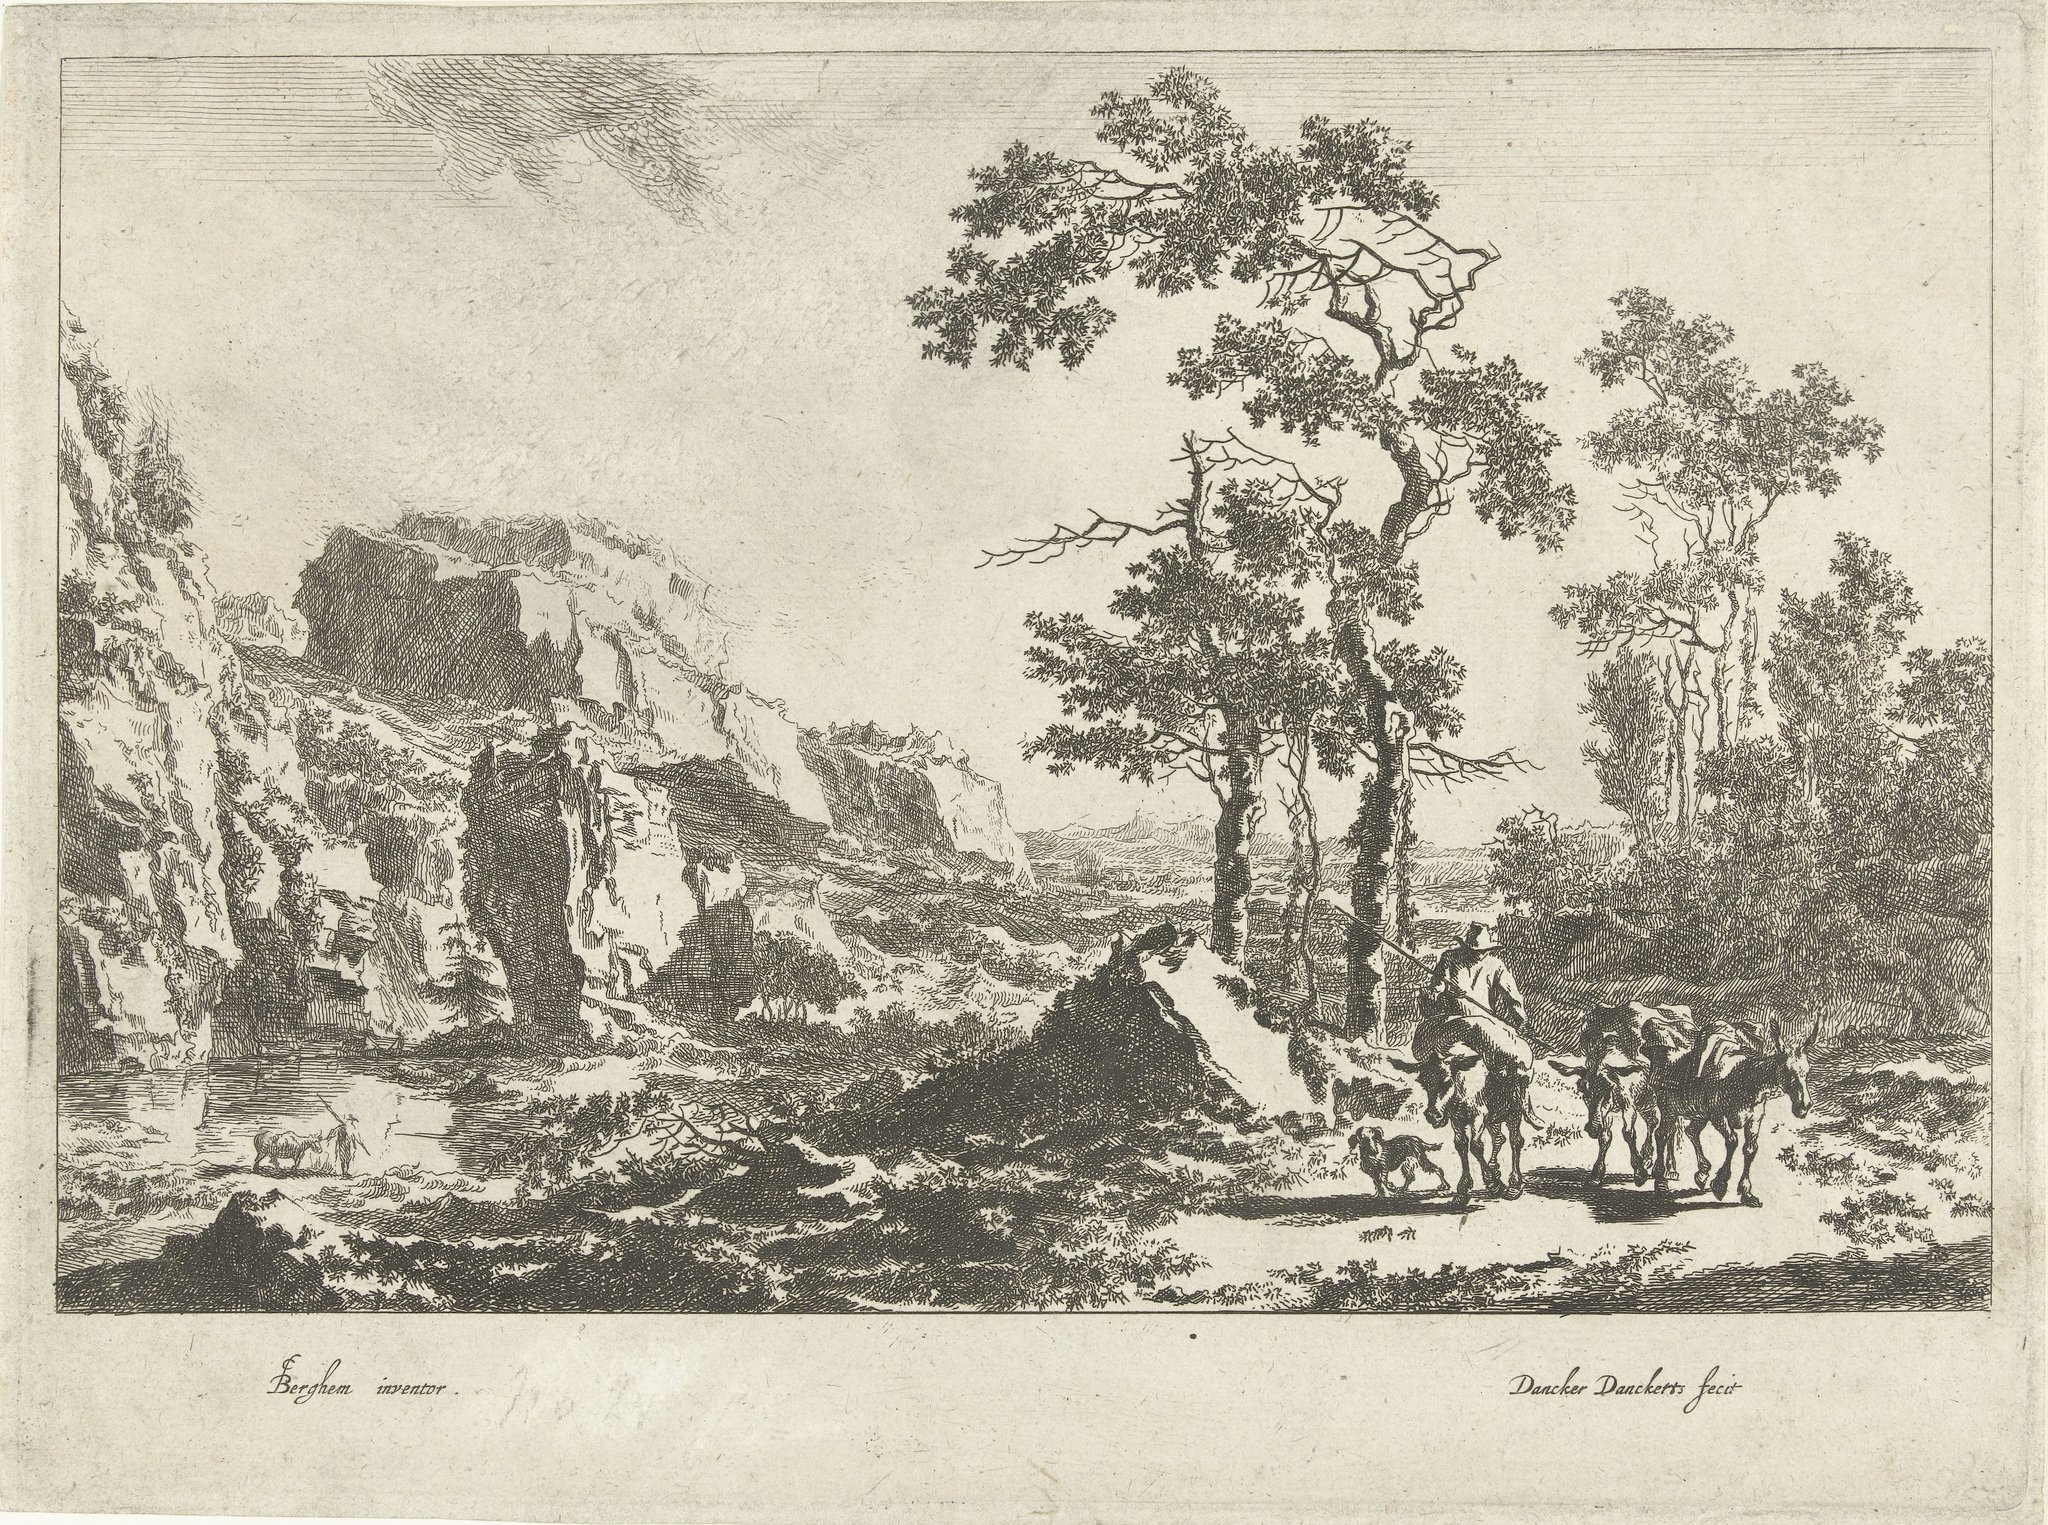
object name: print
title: Italiaans berglandschap met drie muilezels en muilezeldrijver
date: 1643-1666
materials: paper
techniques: etching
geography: netherlands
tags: herding, herdsman, herdswoman, shepherd, shepherdess, cowherd, etc., rocks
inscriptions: collector's mark: Lugt 2760, collector's mark: Lugt 2228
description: Prent uit serie van vier landschappen naar ontwerp van Pieter Nicolaesz. Berchem.